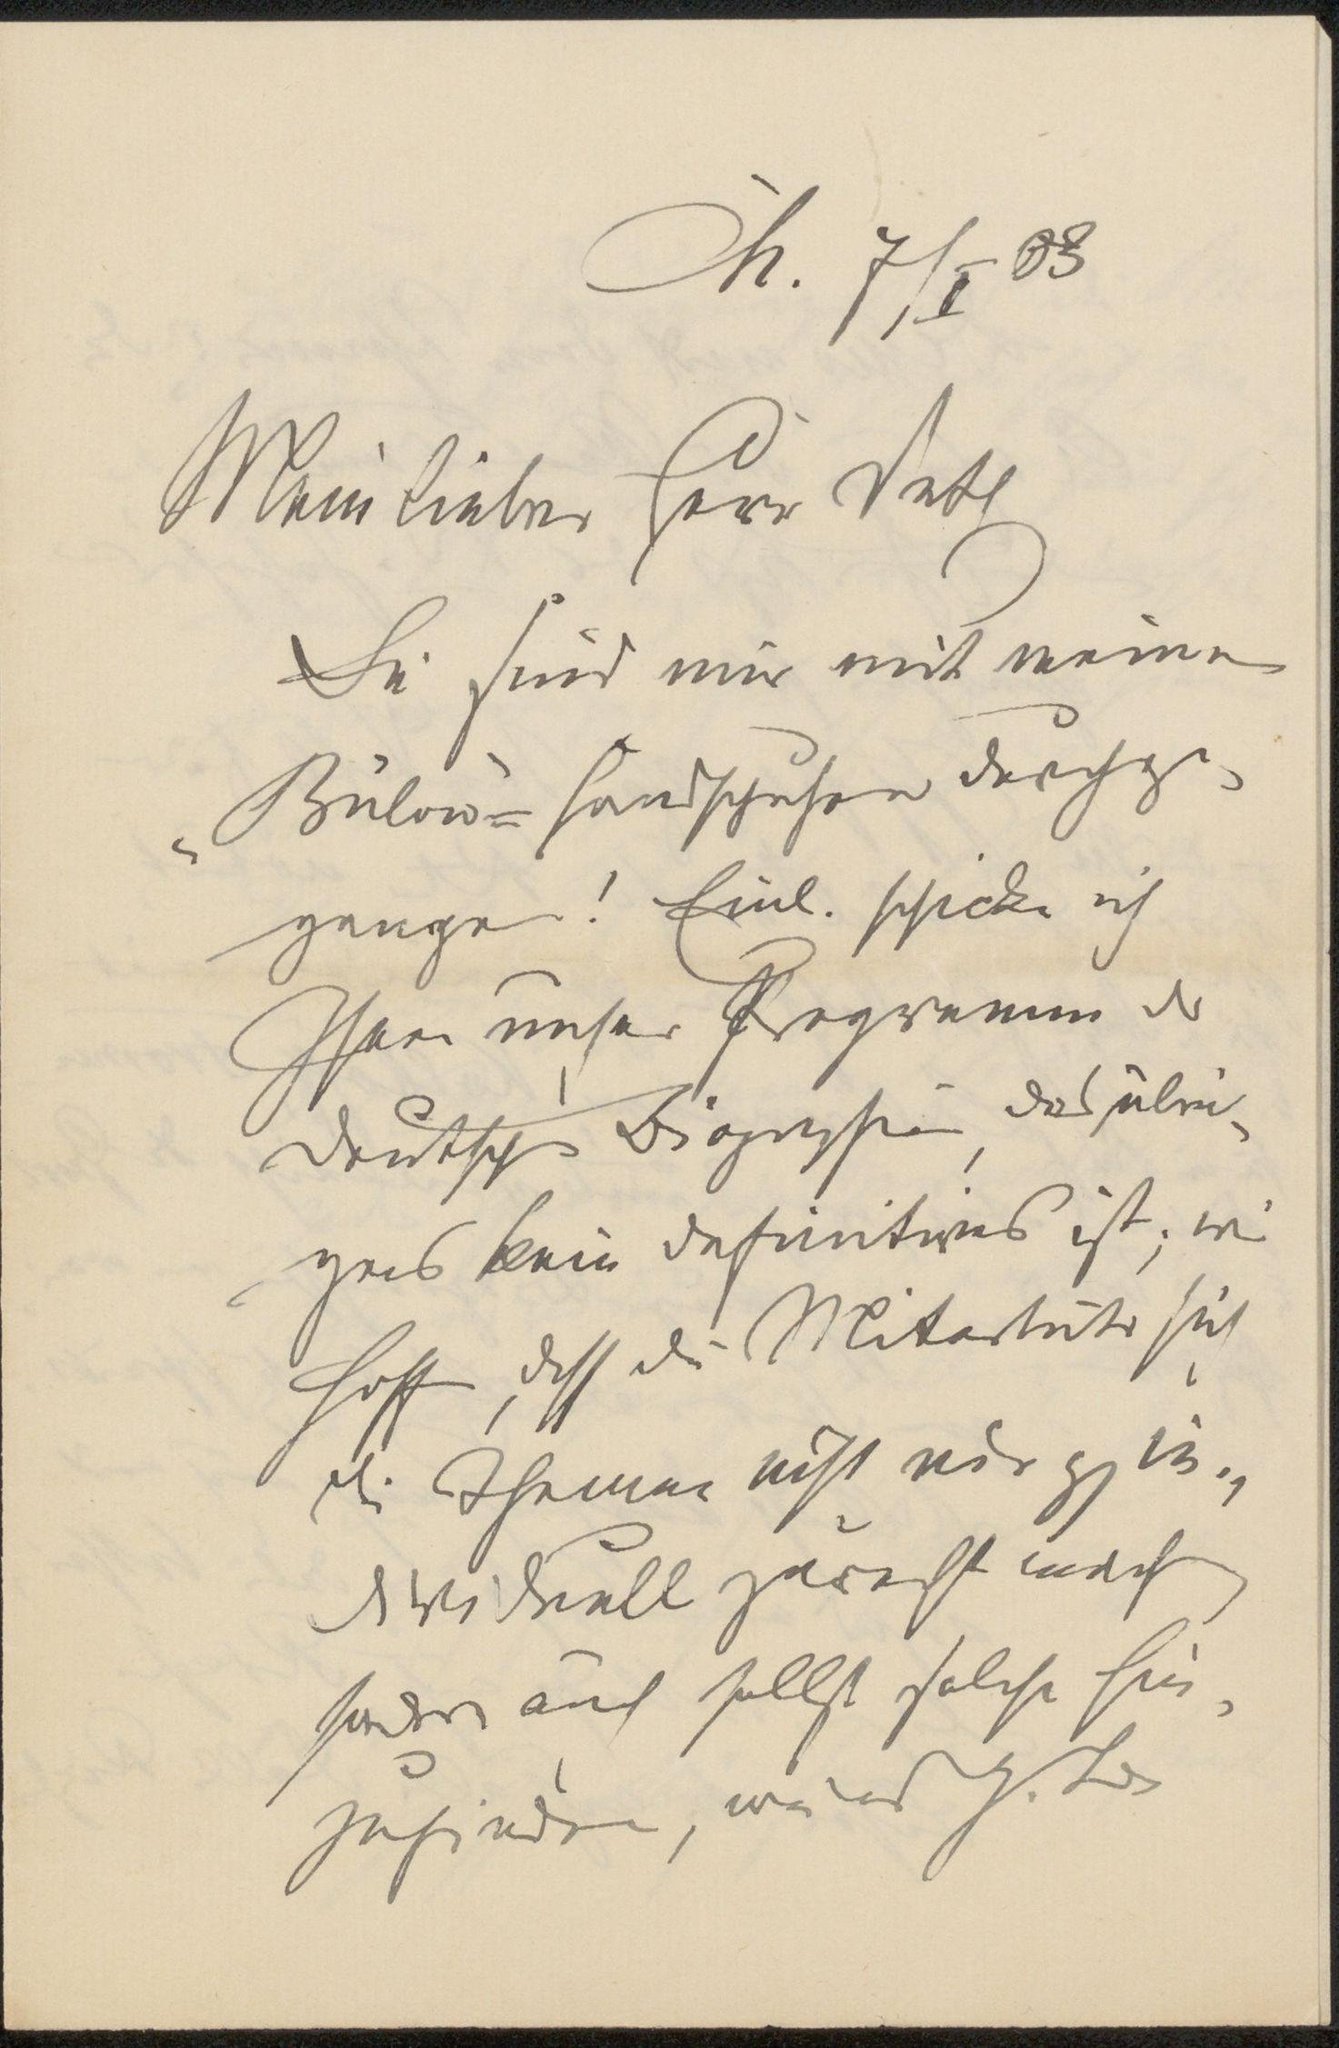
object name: letter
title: Brief aan Jan Veth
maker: wilhelm von bode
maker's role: conservator, kunsthistoricus, museumdirecteur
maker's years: 1845-1929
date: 1903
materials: ink, paper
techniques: pen, writing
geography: charlottenburg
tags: painter, print maker, draughtsman, designer, jan veth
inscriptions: watermark, collector's mark: ‘RPK’